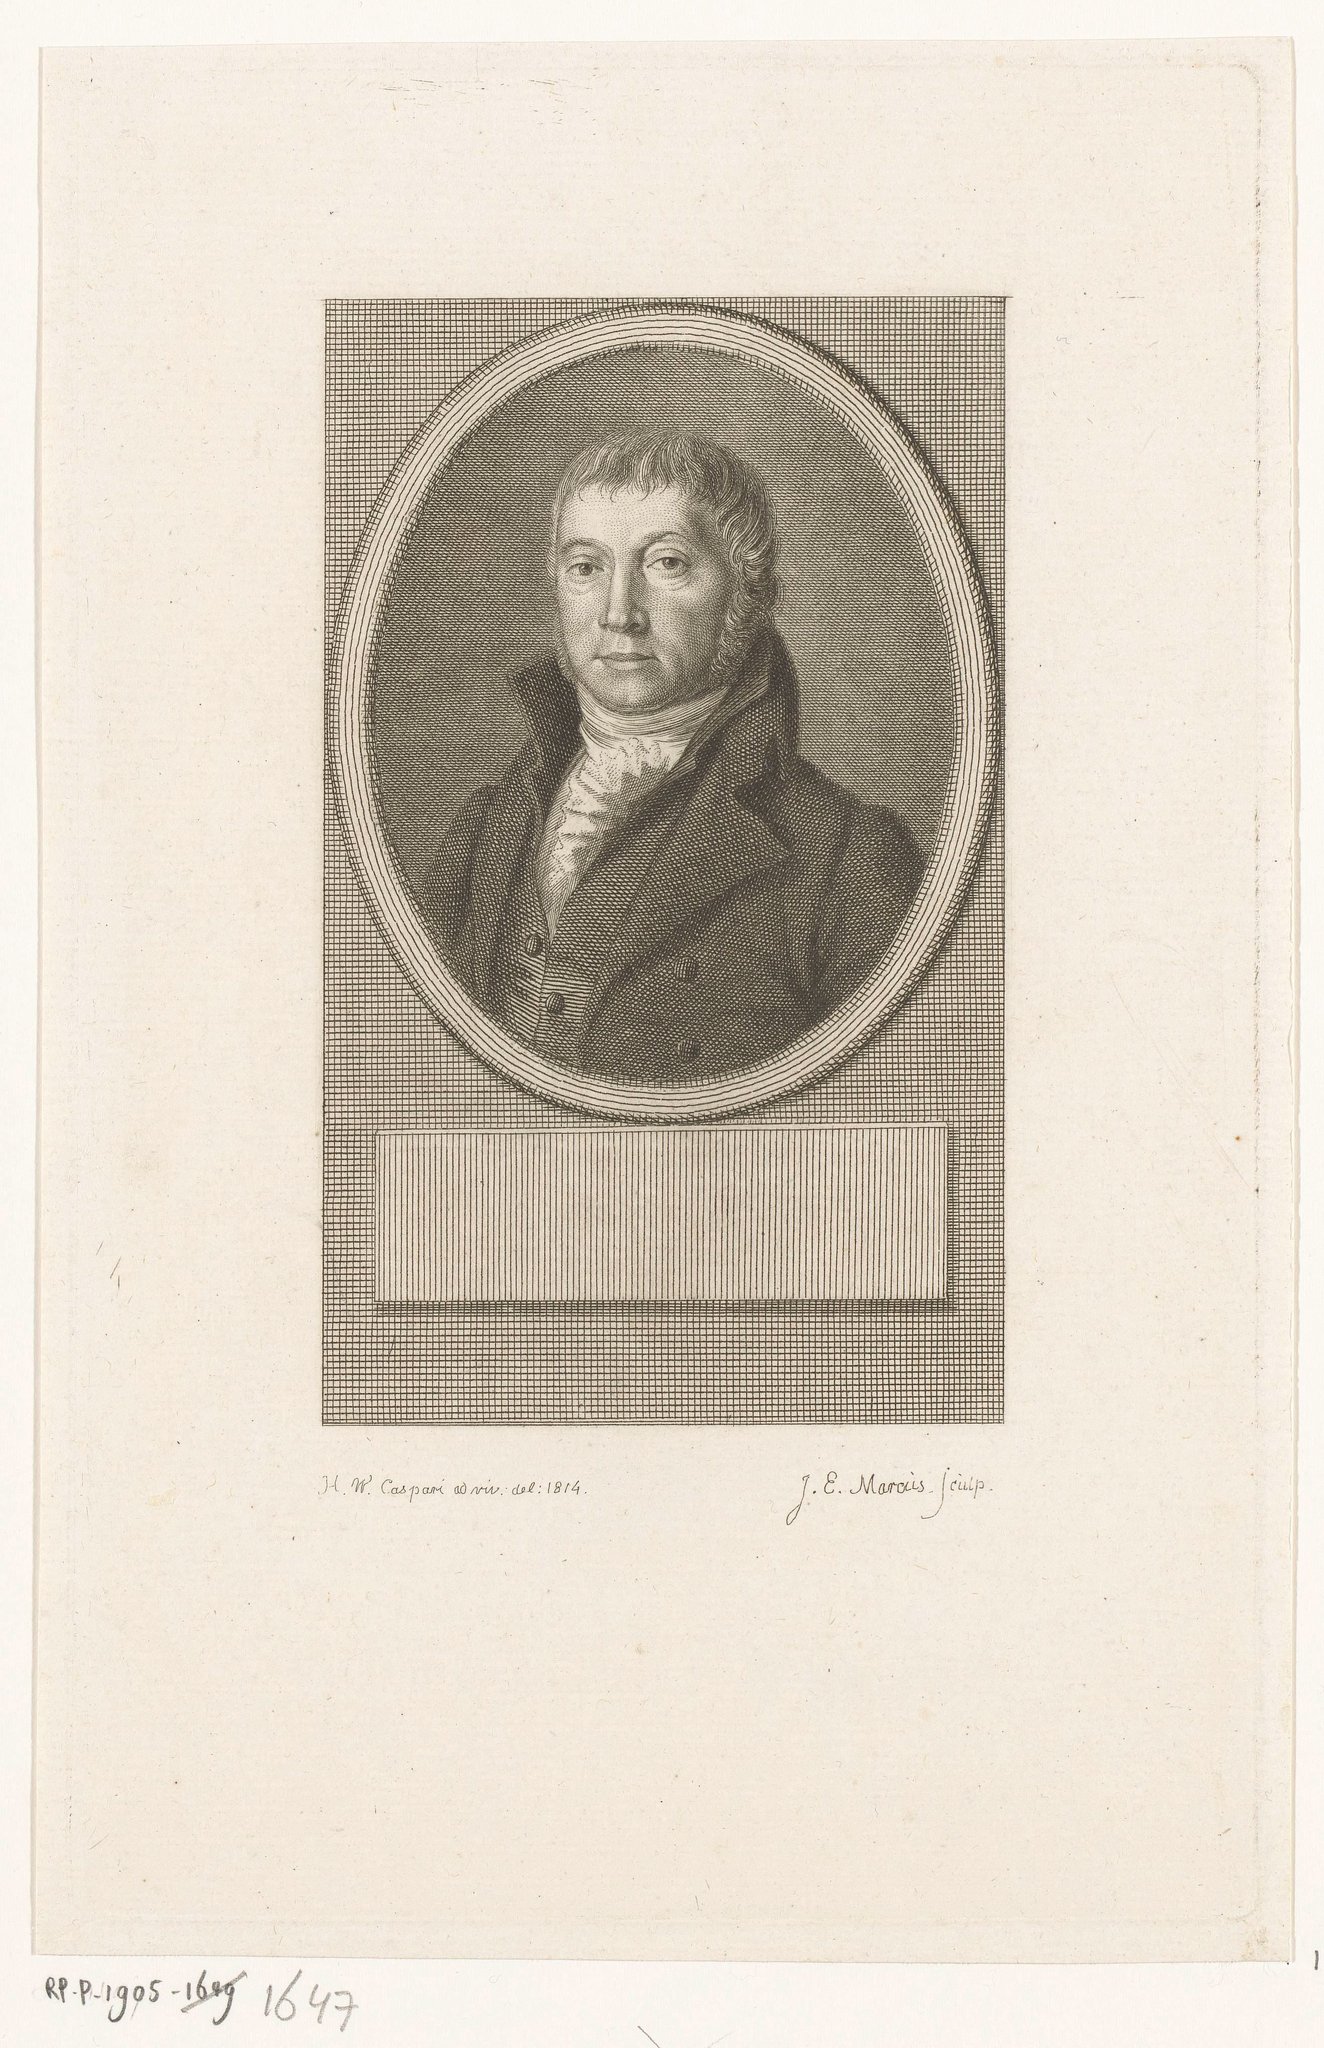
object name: print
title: Portret van Cornelis Anthony Fannius Scholten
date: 1814-1817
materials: paper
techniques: etching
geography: amsterdam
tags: the hague, cornelis anthony fannius scholten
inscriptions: collector's mark: Lugt 2228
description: Latere staat van de prent ook gebruikt in: Herman Bosscha, Geschiedenis der Nederlandsche staatsomwenteling in 1813. 4 dln. Amsterdam: P. den Hengt en zn. en J. van der Hey, 1817.